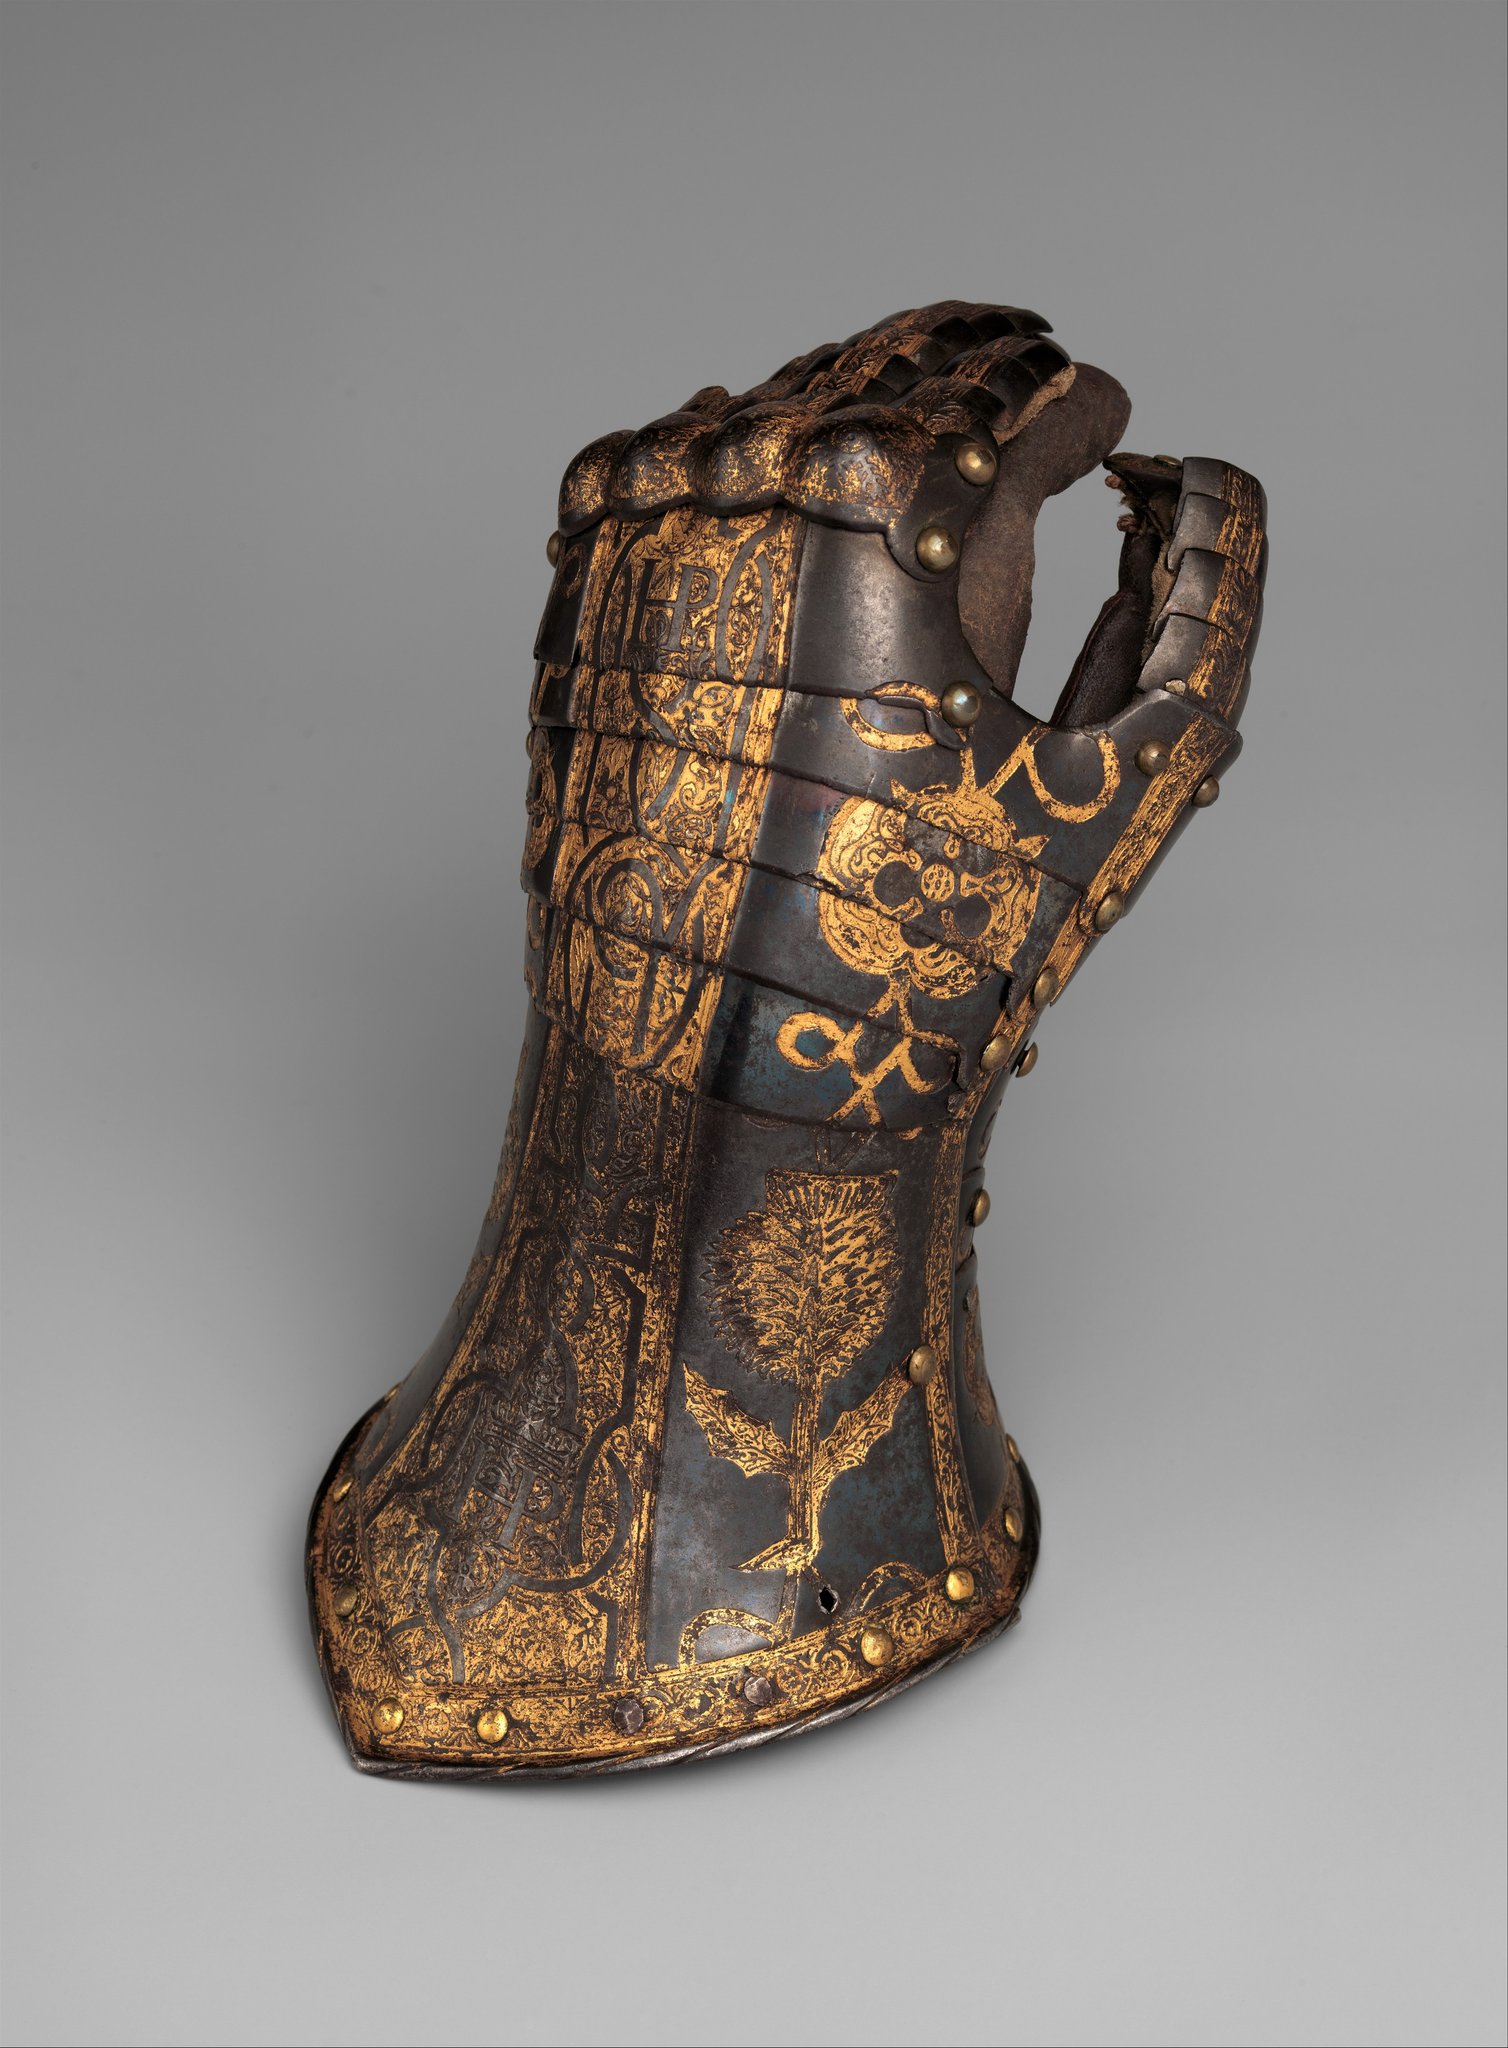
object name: left gauntlet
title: Left Gauntlet of Henry (1594–1612), Prince of Wales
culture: british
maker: jacob halder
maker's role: armorer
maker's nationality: british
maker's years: 1558-1608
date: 1608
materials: gold, leather, steel, textile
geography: england